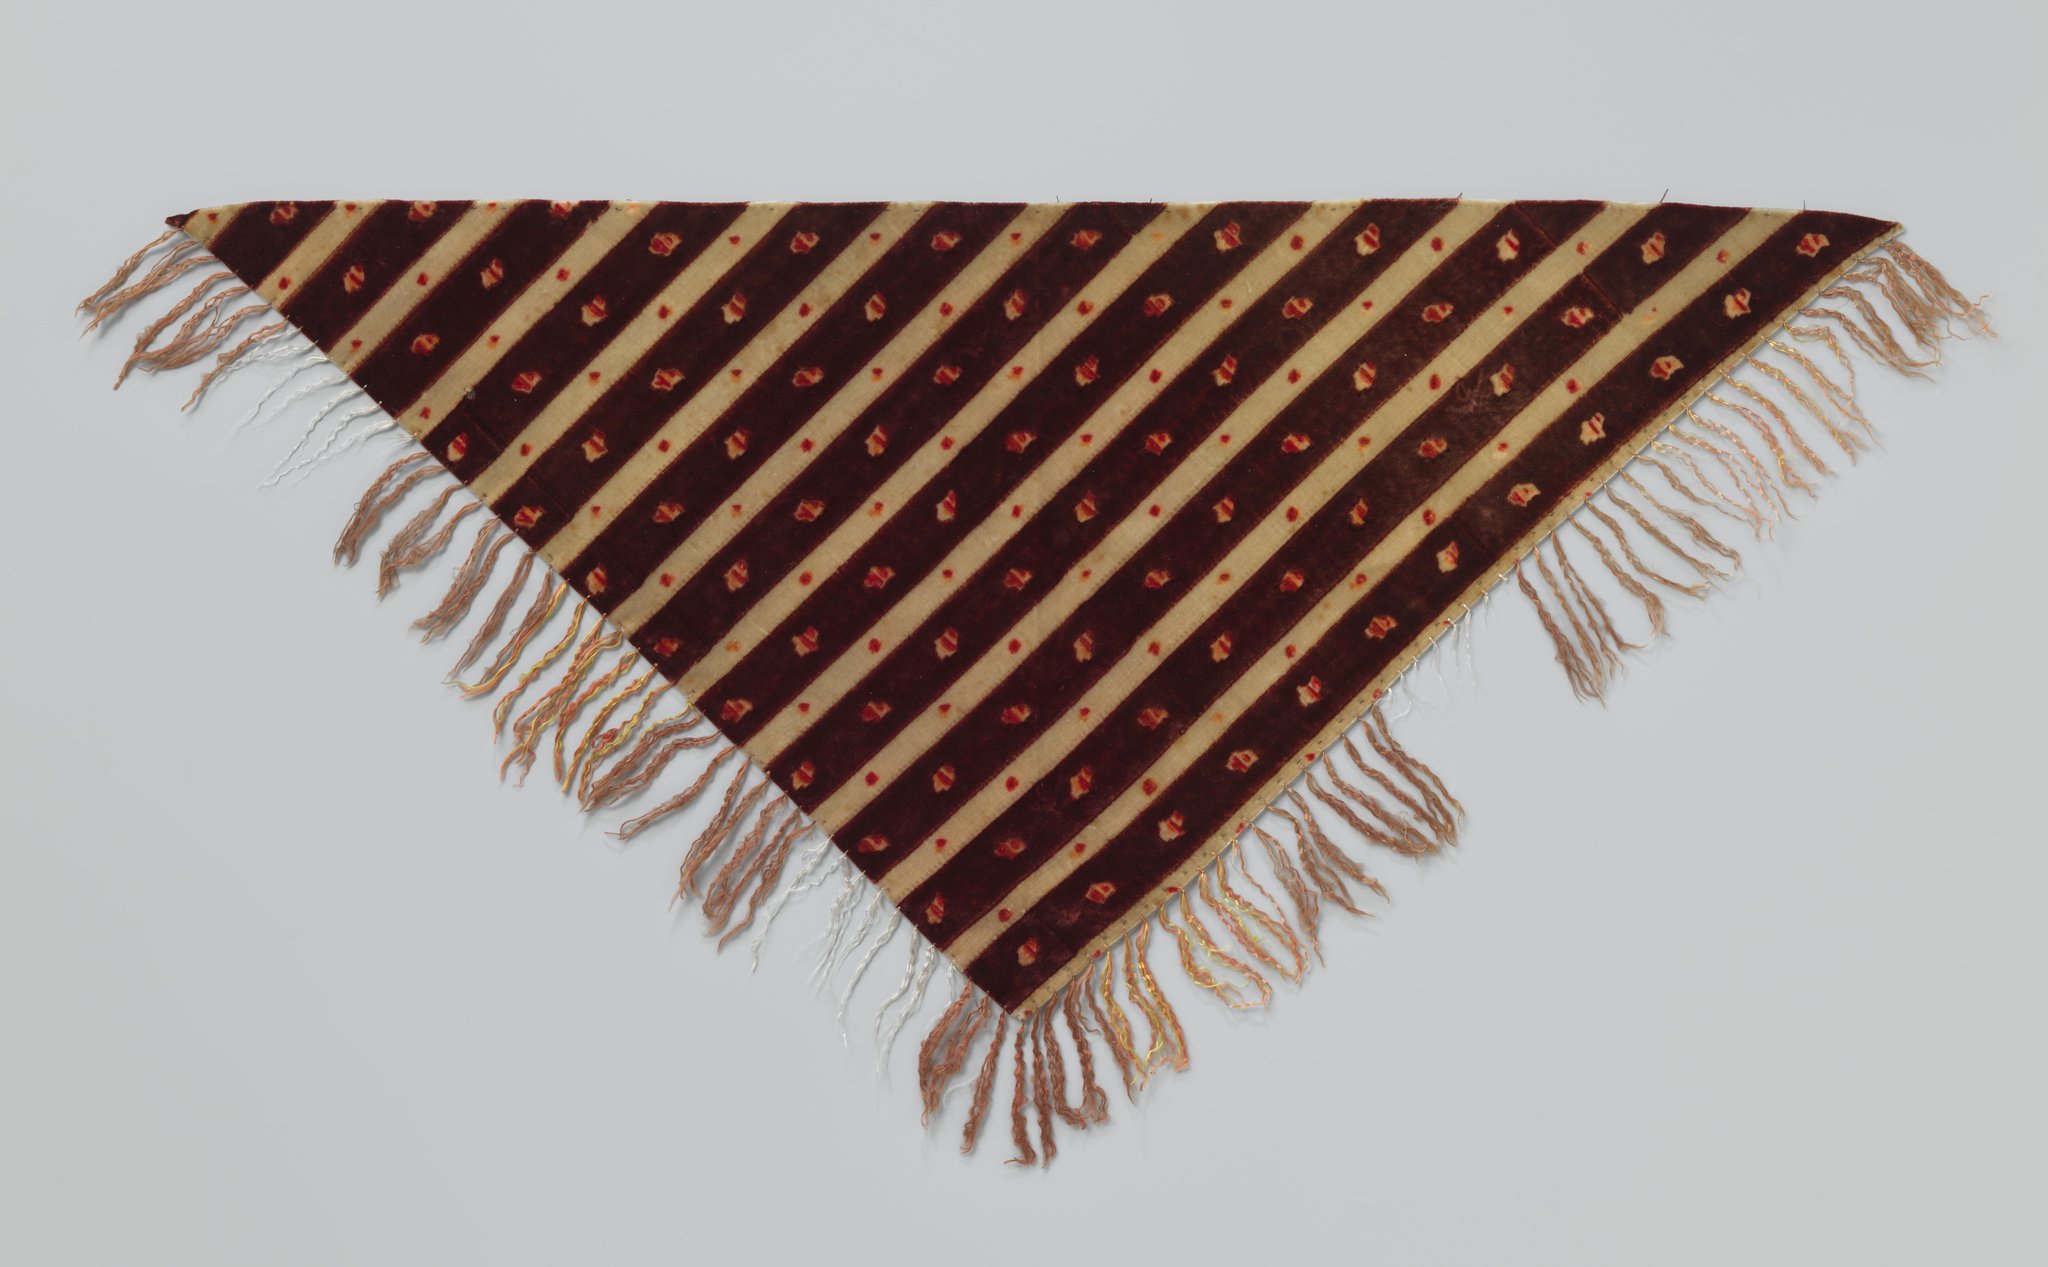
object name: omslagdoek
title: Gestreepte driehoekige omslagdoek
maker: Anonymous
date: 1770-1800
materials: silk, velvet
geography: england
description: Driehoekige omslagdoek met franje aan de twee korte zijden.